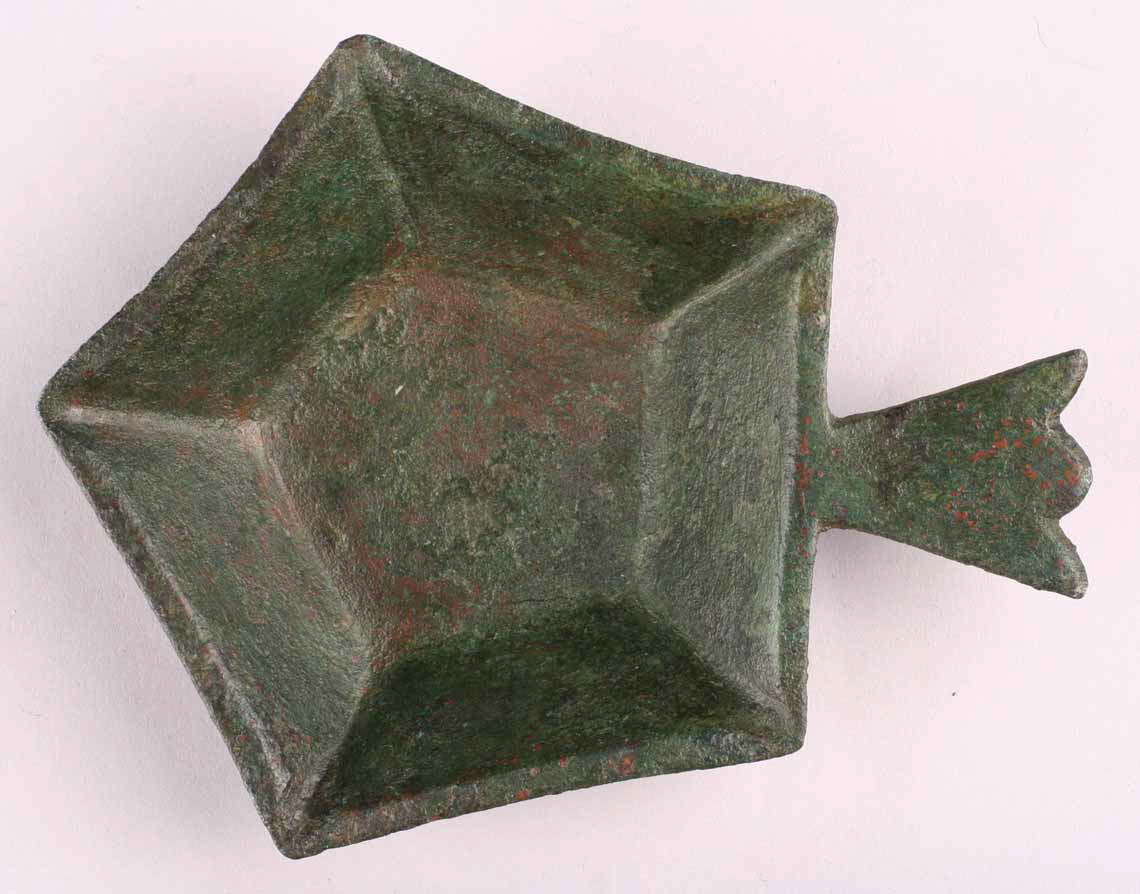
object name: dish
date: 1001-1200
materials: bronze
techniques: casting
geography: iran